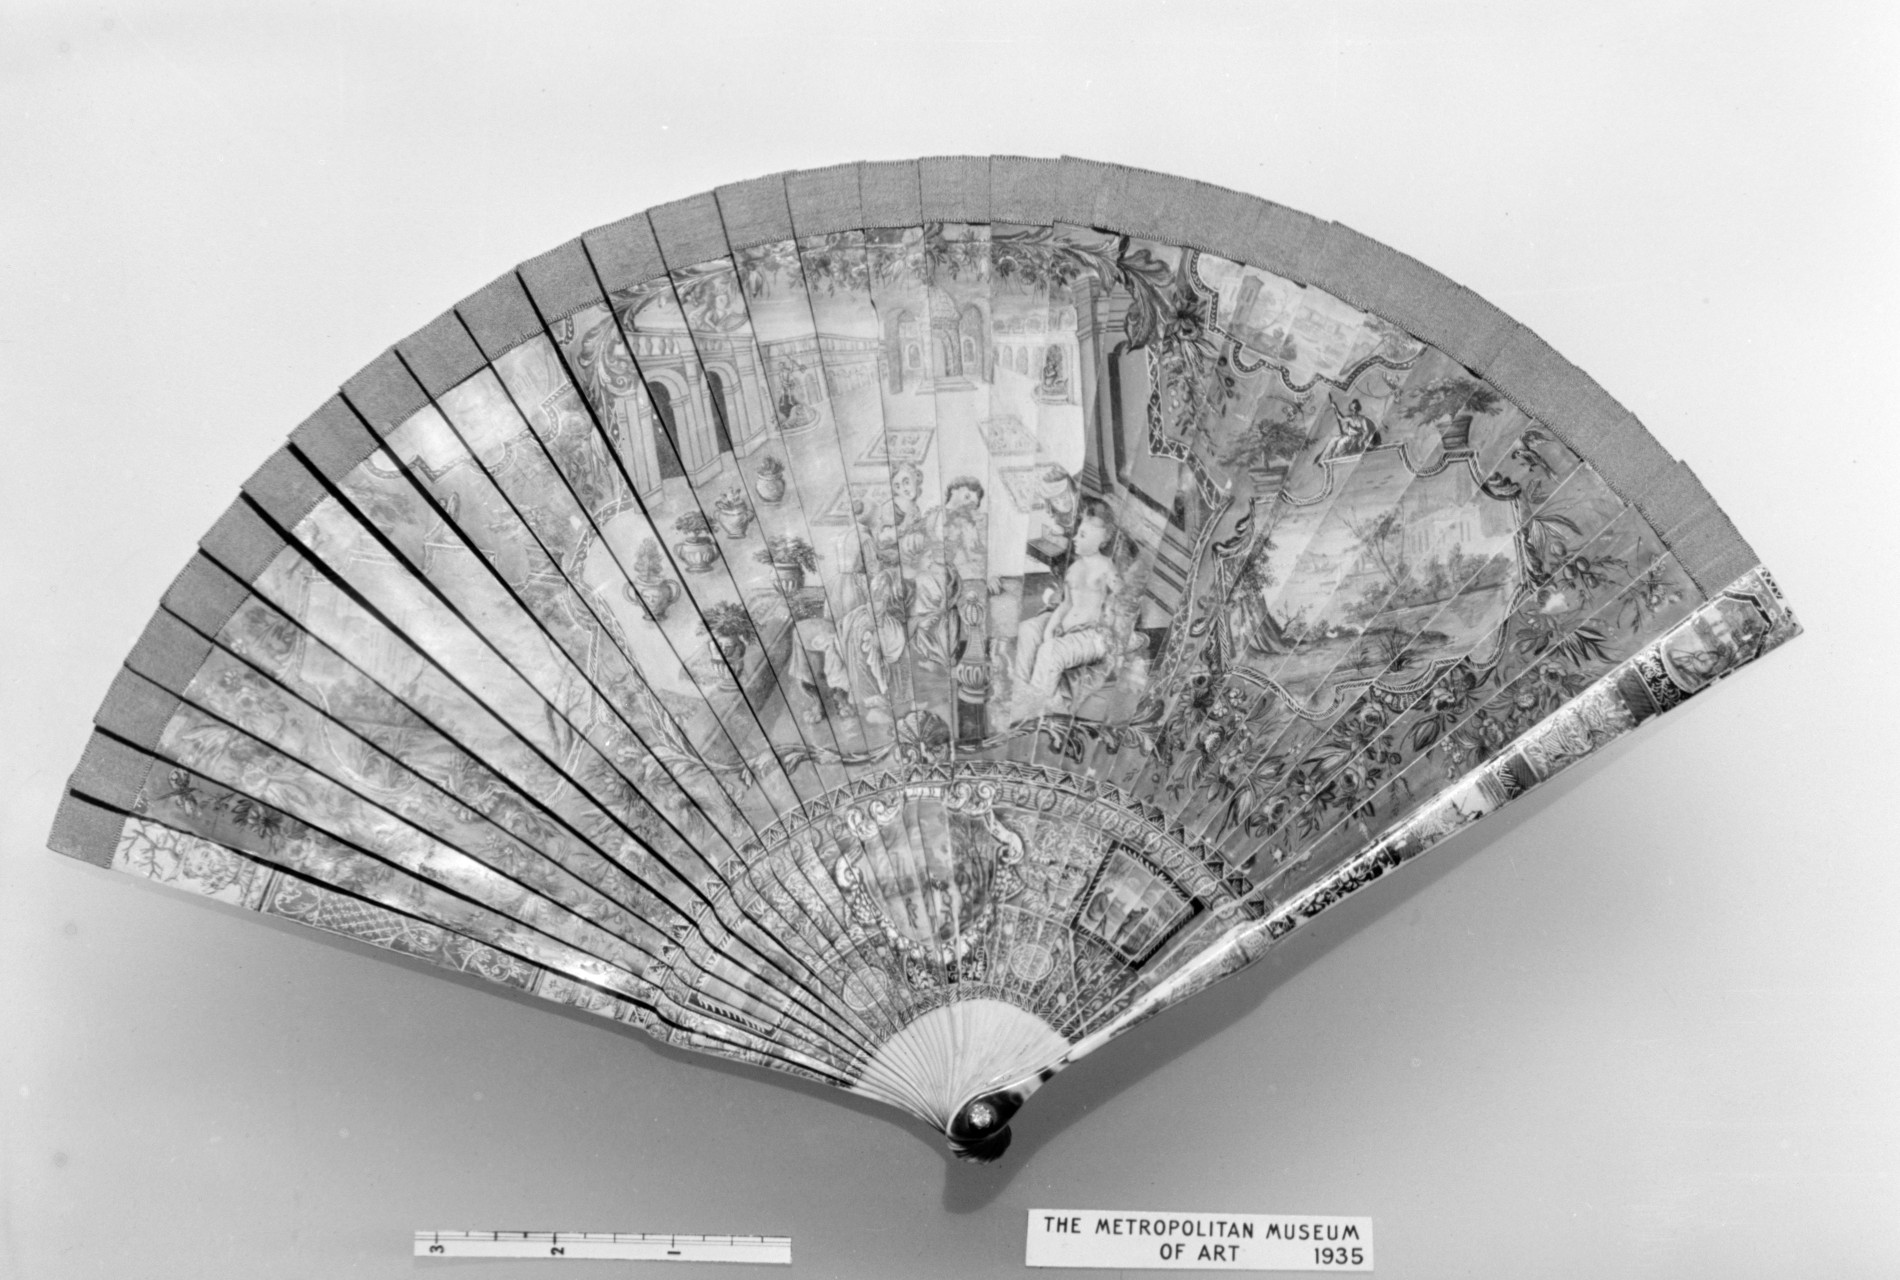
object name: fan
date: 1715-1723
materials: ivory, shell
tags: women,female nudes